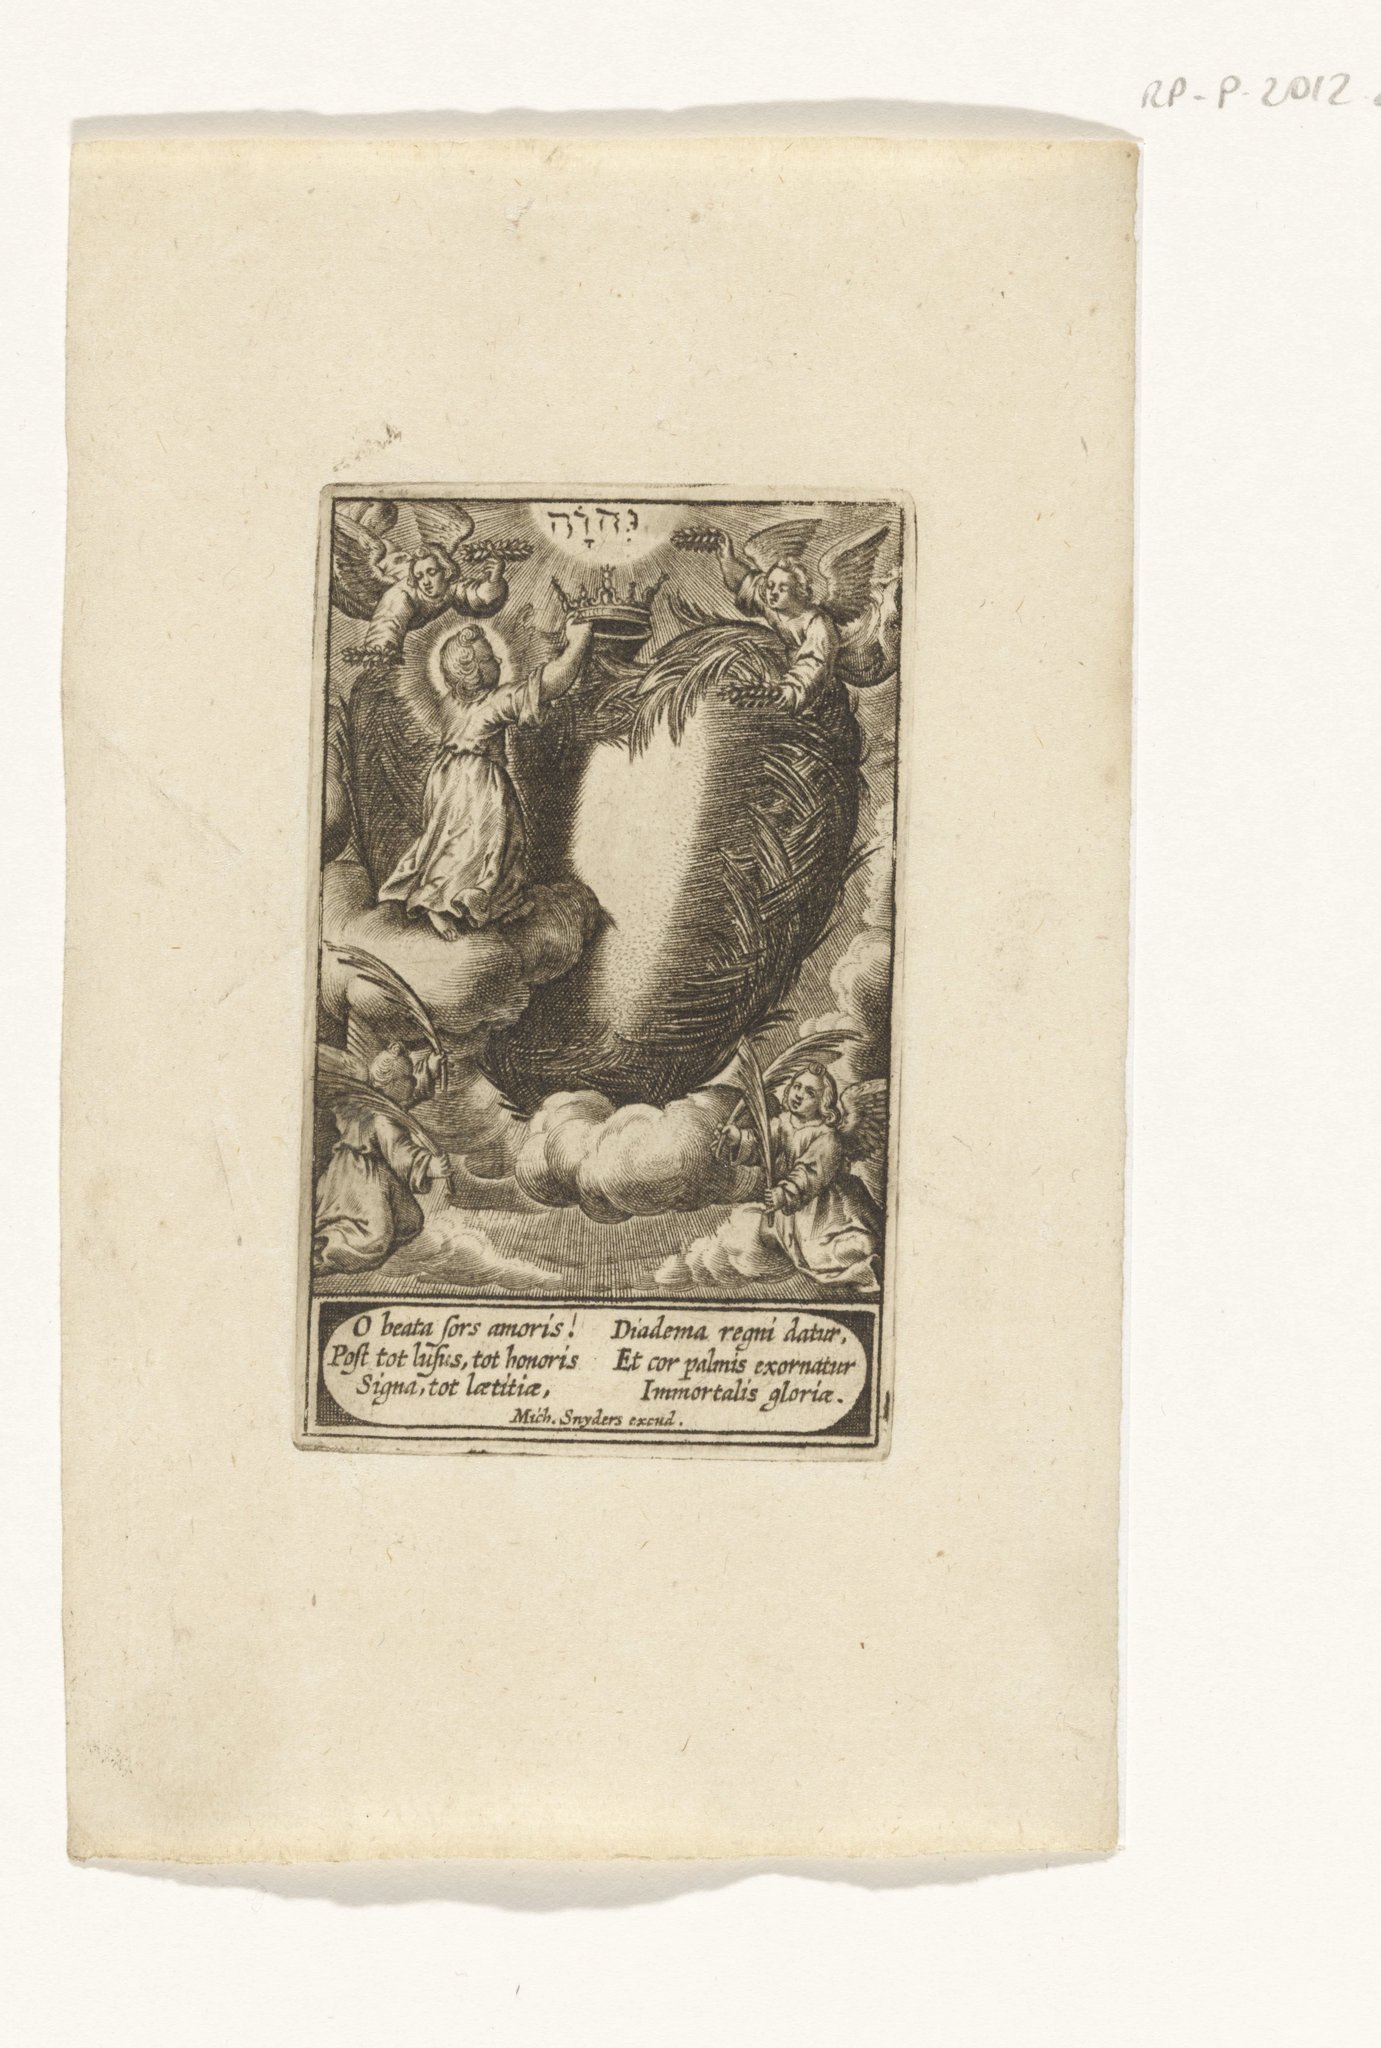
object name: print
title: Cor Iesu amanti sacrum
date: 1630-1650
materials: paper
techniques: engraving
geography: antwerp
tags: the sacred heart, regular clerics, e.g. jesuits, redemptorists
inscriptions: collector's mark: Lugt 2760, collector's mark: Lugt 2228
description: Het heilige hart door Christus gekroond. Onderdeel van een serie van zeventien prenten over het menselijke hart overwonnen door het Christuskind, een thema gerelateerd aan de jezuïeten.